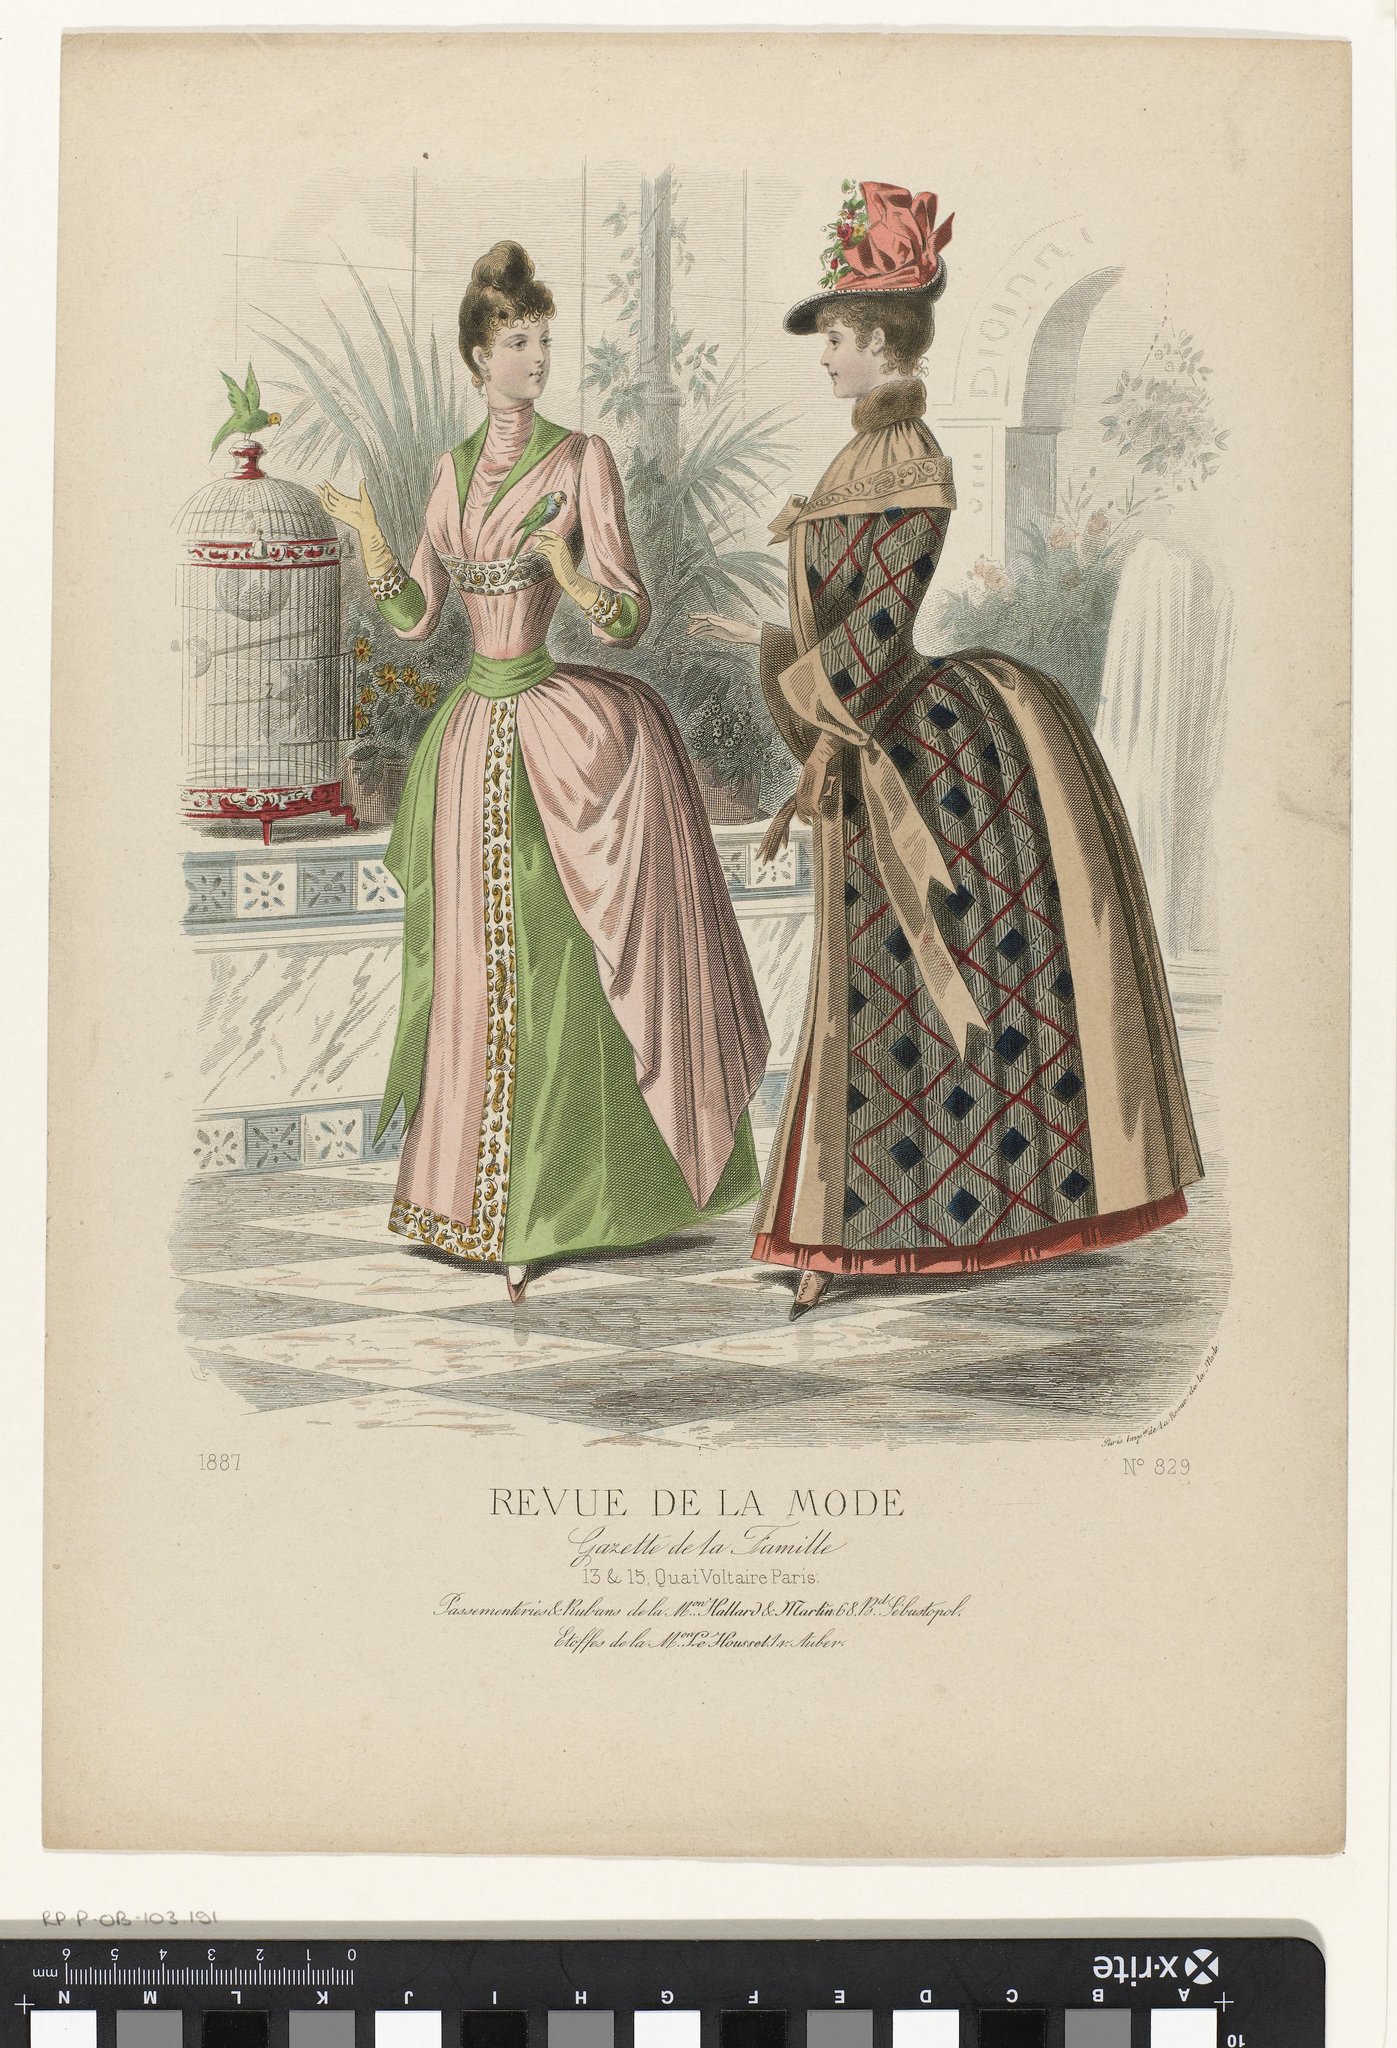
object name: fashion print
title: Revue de la Mode, Gazette de la Famille, 20 novembre 1887, 16e Année, No. 829: Passementeries & Rubans (...)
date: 1887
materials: paper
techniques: engraving, hand coloring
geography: paris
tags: empty bird cage, border, ribbon, braid (+ women's clothes), gloves, mittens (short gloves) (+ women's clothes), neck-gear: collar (+ feathers used for clothes), coat (+ women's clothes), fashion plates, head-gear: hat (+ women's clothes), skirt (+ women's clothes), belt, girdle, waistband (+ women's clothes)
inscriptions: address: ‘13 & 15, Quai Voltaire Paris’, title: ‘REVUE DE LA MODE / Gazette de la Famille’, caption: ‘Passementeries & Rubans de la M.on Hallard & Martin, 68, B.d Sébastopol. Etoffes de la M.on Le Houssel 1 r. Auber.’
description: Twee vrouwen in een serre, staande bij een geopende vogelkooi waarop een vogel (parkiet?) zit. Links: 'toilette' van lichtgroen fluweel, roze surah en goudkleurige galon, geschikt voor een jonge vrouw van 18 a 20 jaar. Ceintuur van lichtgroen fluweel. Rechts: lange mantel van beige wol, wol met strepen en ruiten in beige, zwart en rood. Kraag van veren. Manchetten van beige wol. Strik van beige lint met lange slippen, aan de voorzijde bevestigd aan de rand van de capuchon. Onder de voorstelling enkele regels reclametekst voor verschillende producten. Prent uit het modetijdschrift Revue de la Mode (1872-1913). Uitgebreide beschrijving van de kleding op pagina 376 "PLANCHE COLORIÉE.